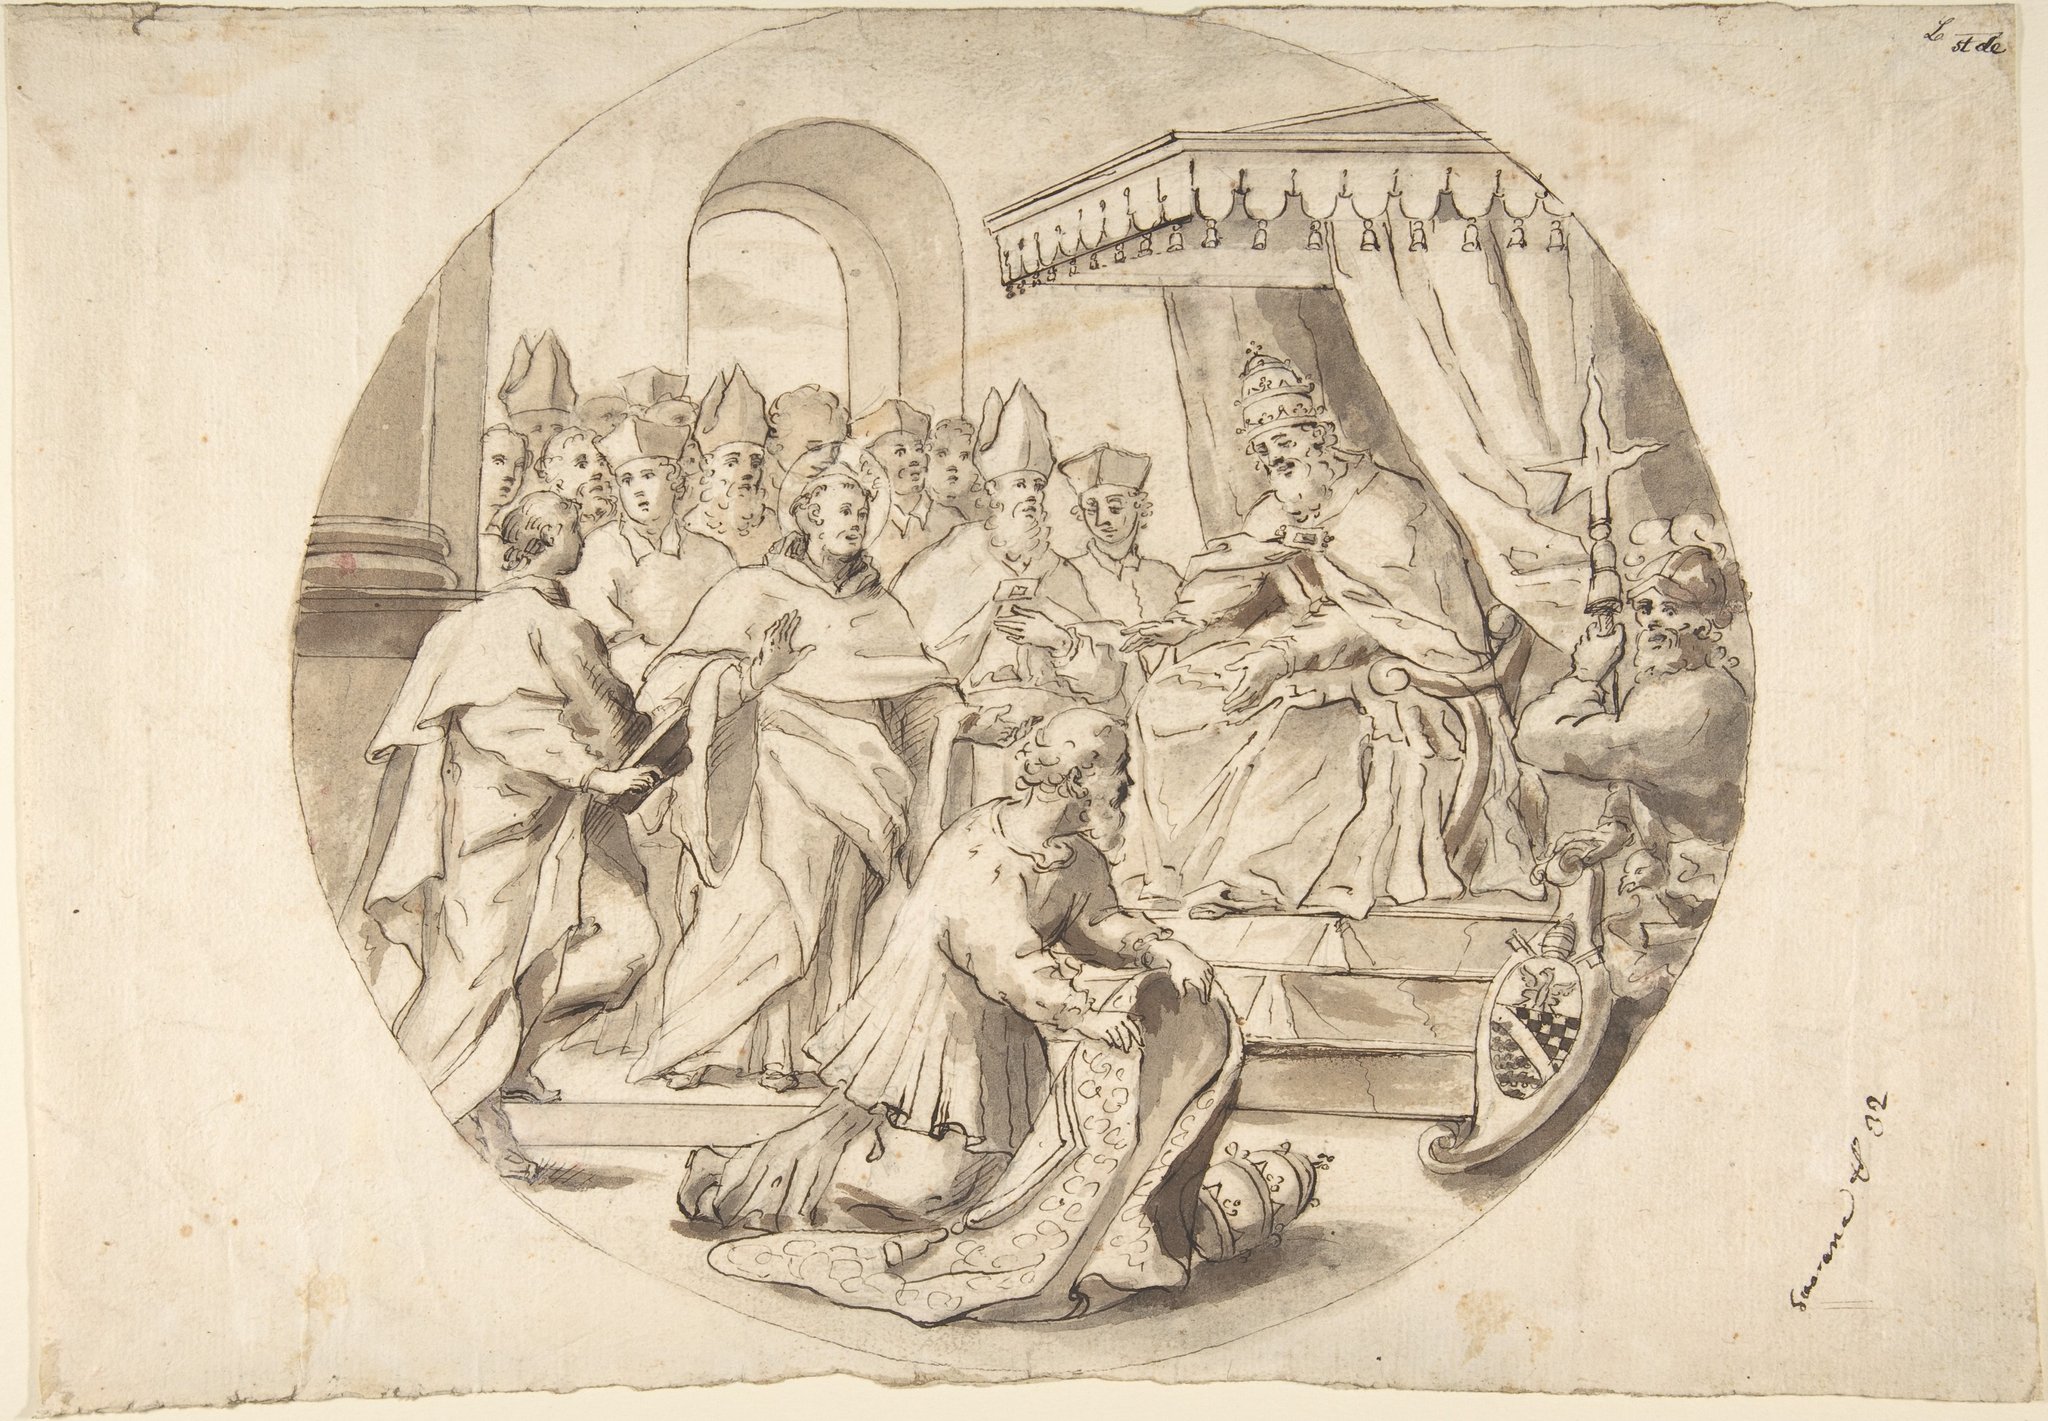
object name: drawing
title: A Pope Recieving a Saint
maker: anonymous, german, 18th century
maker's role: artist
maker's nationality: german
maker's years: 1700-1800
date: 1701-1800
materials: chalk, ink, paper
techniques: brush, pen, wash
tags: popes,saints